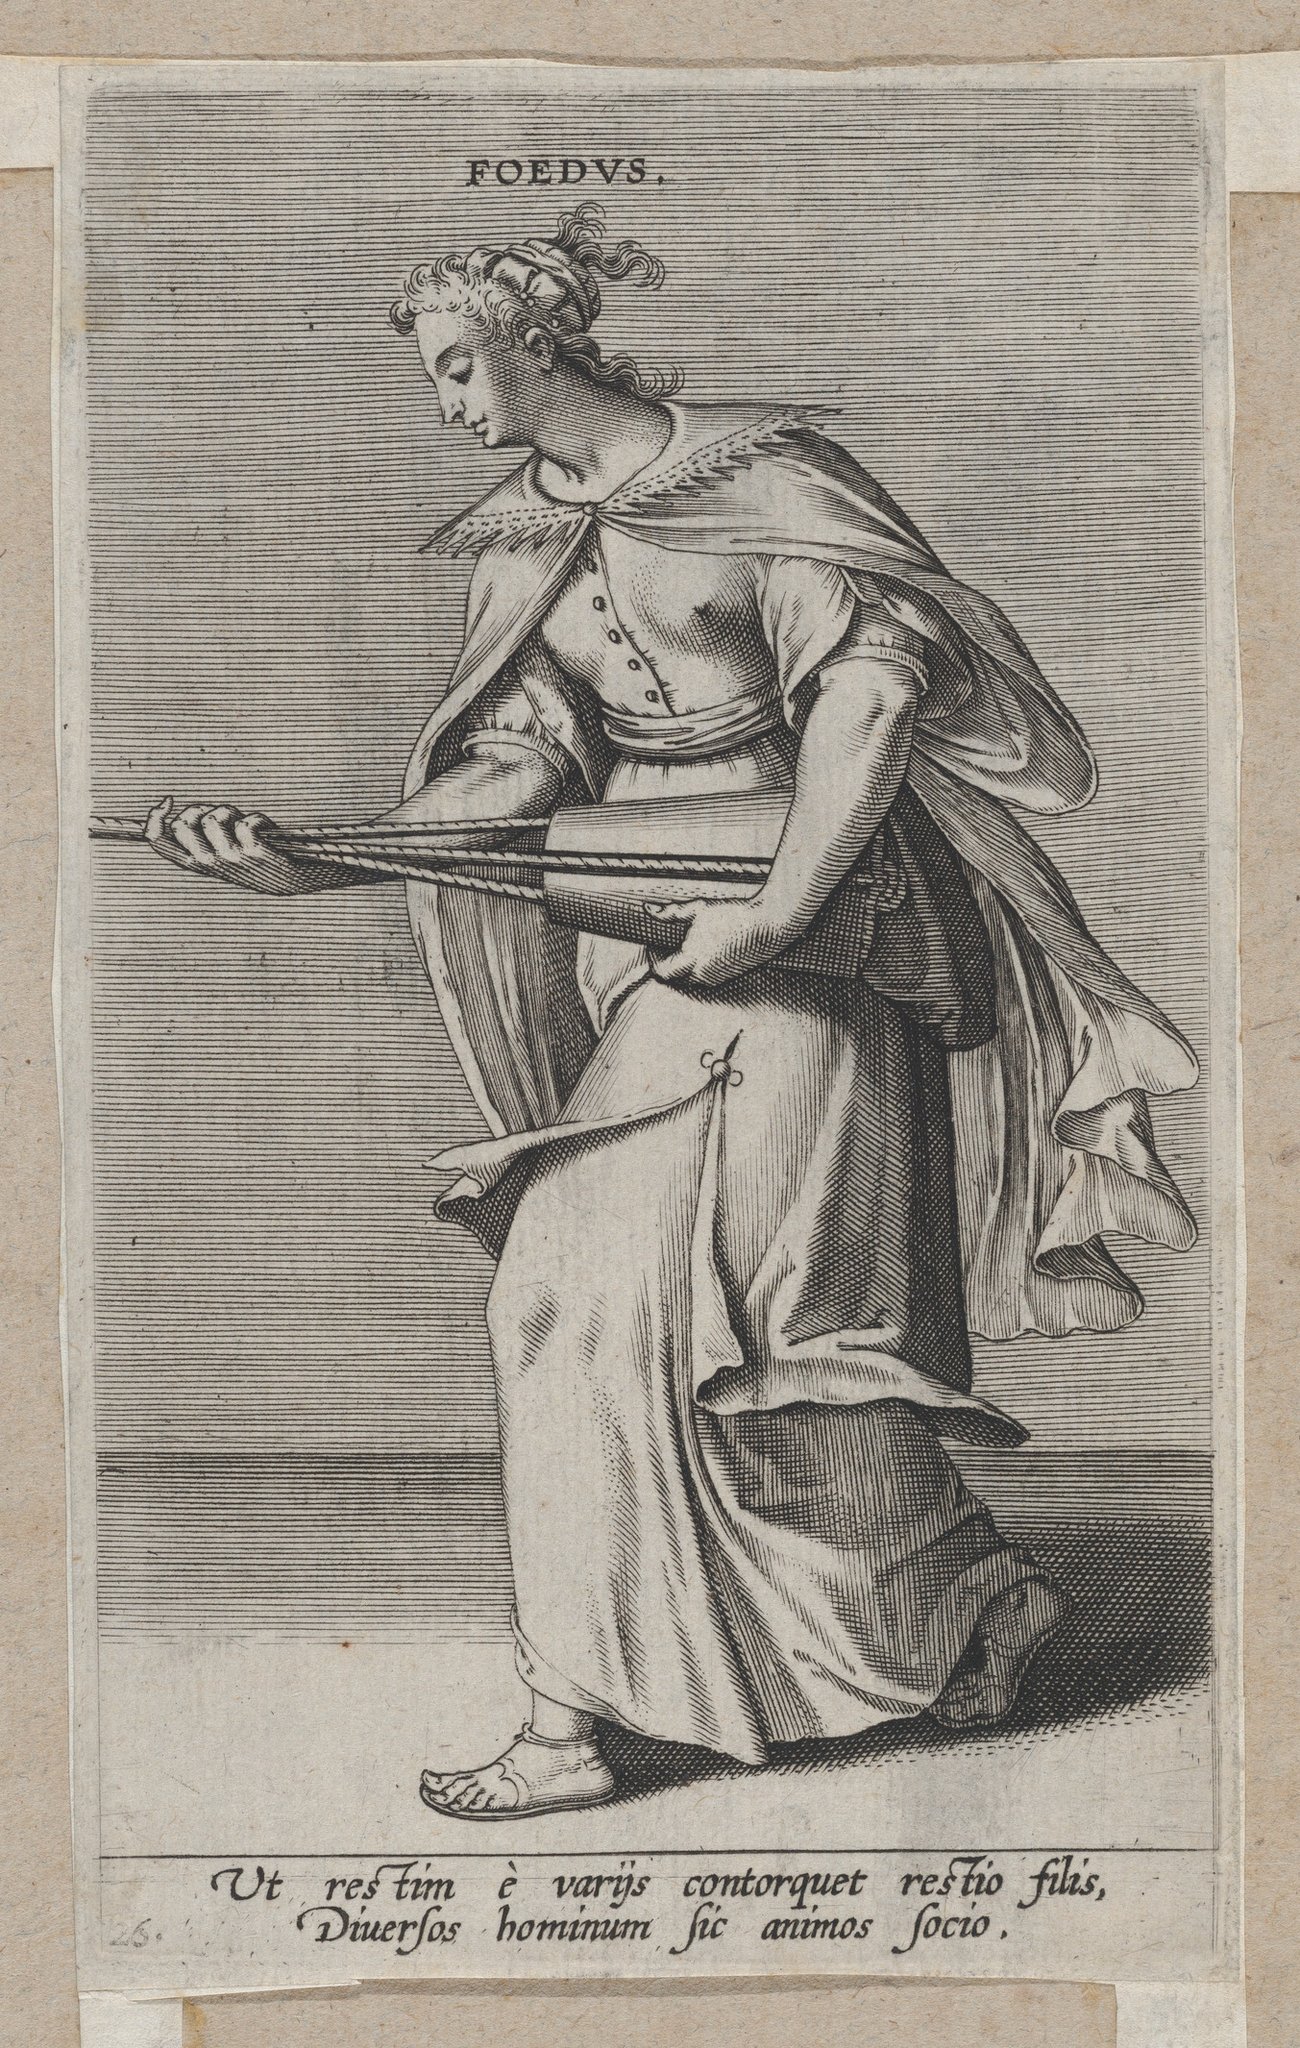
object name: print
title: Foedus, from "Proposopographia"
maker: philips galle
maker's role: artist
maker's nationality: netherlandish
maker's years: 1537-1612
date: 1585-1590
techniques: engraving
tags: musical instruments,women